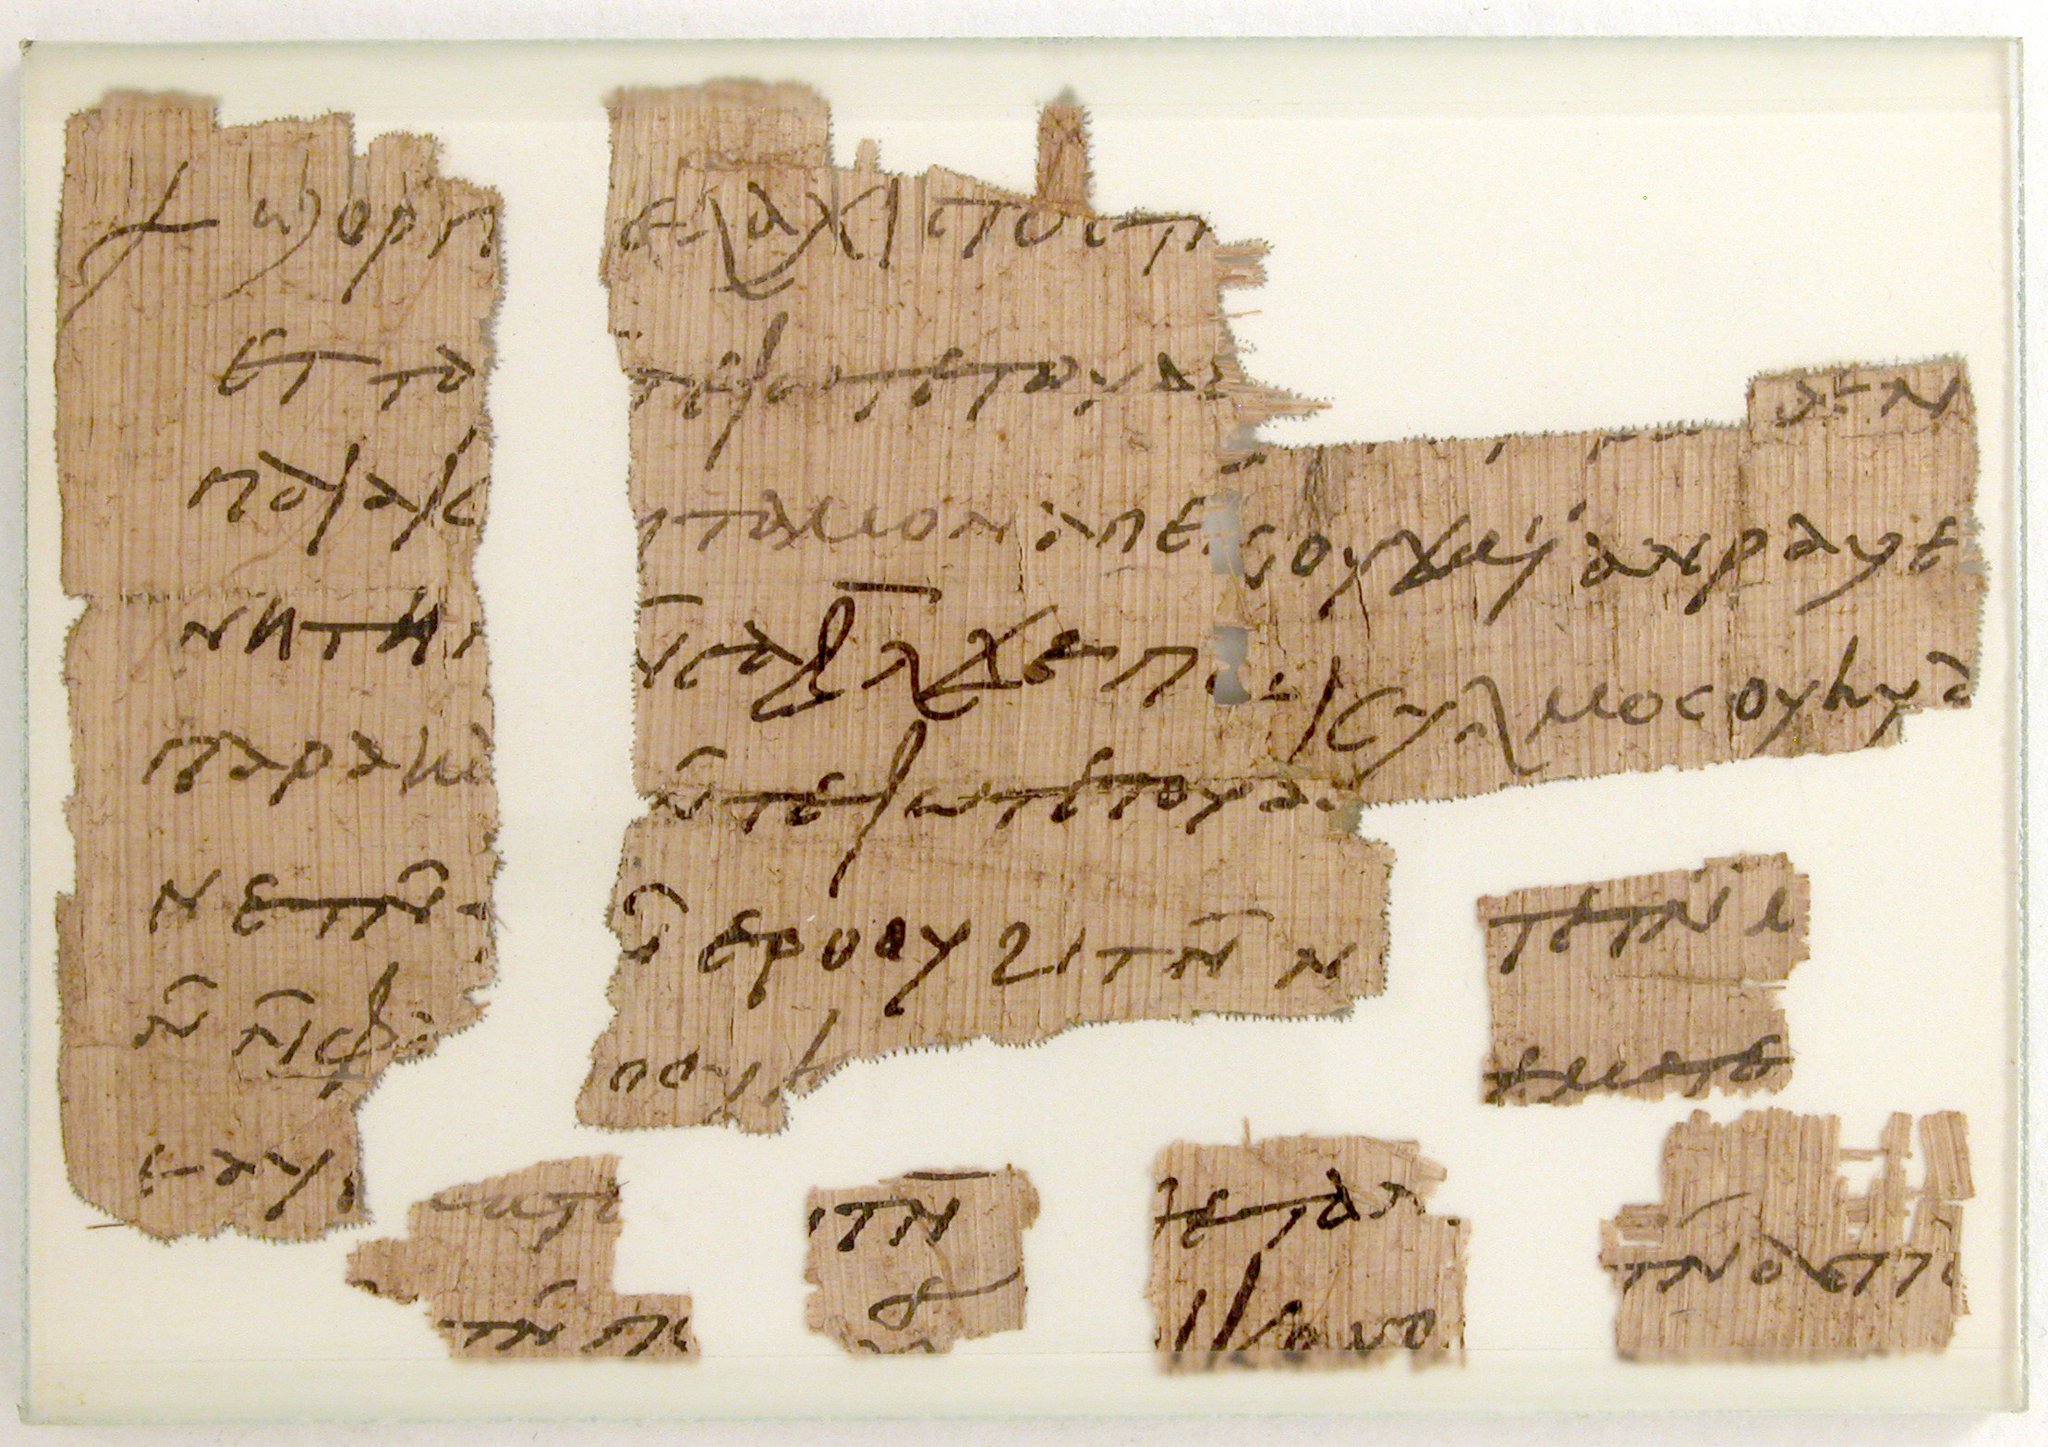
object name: fragment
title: Papyri Fragments of a Letter to Pesenthius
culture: coptic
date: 601-700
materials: ink, papyrus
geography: egypt